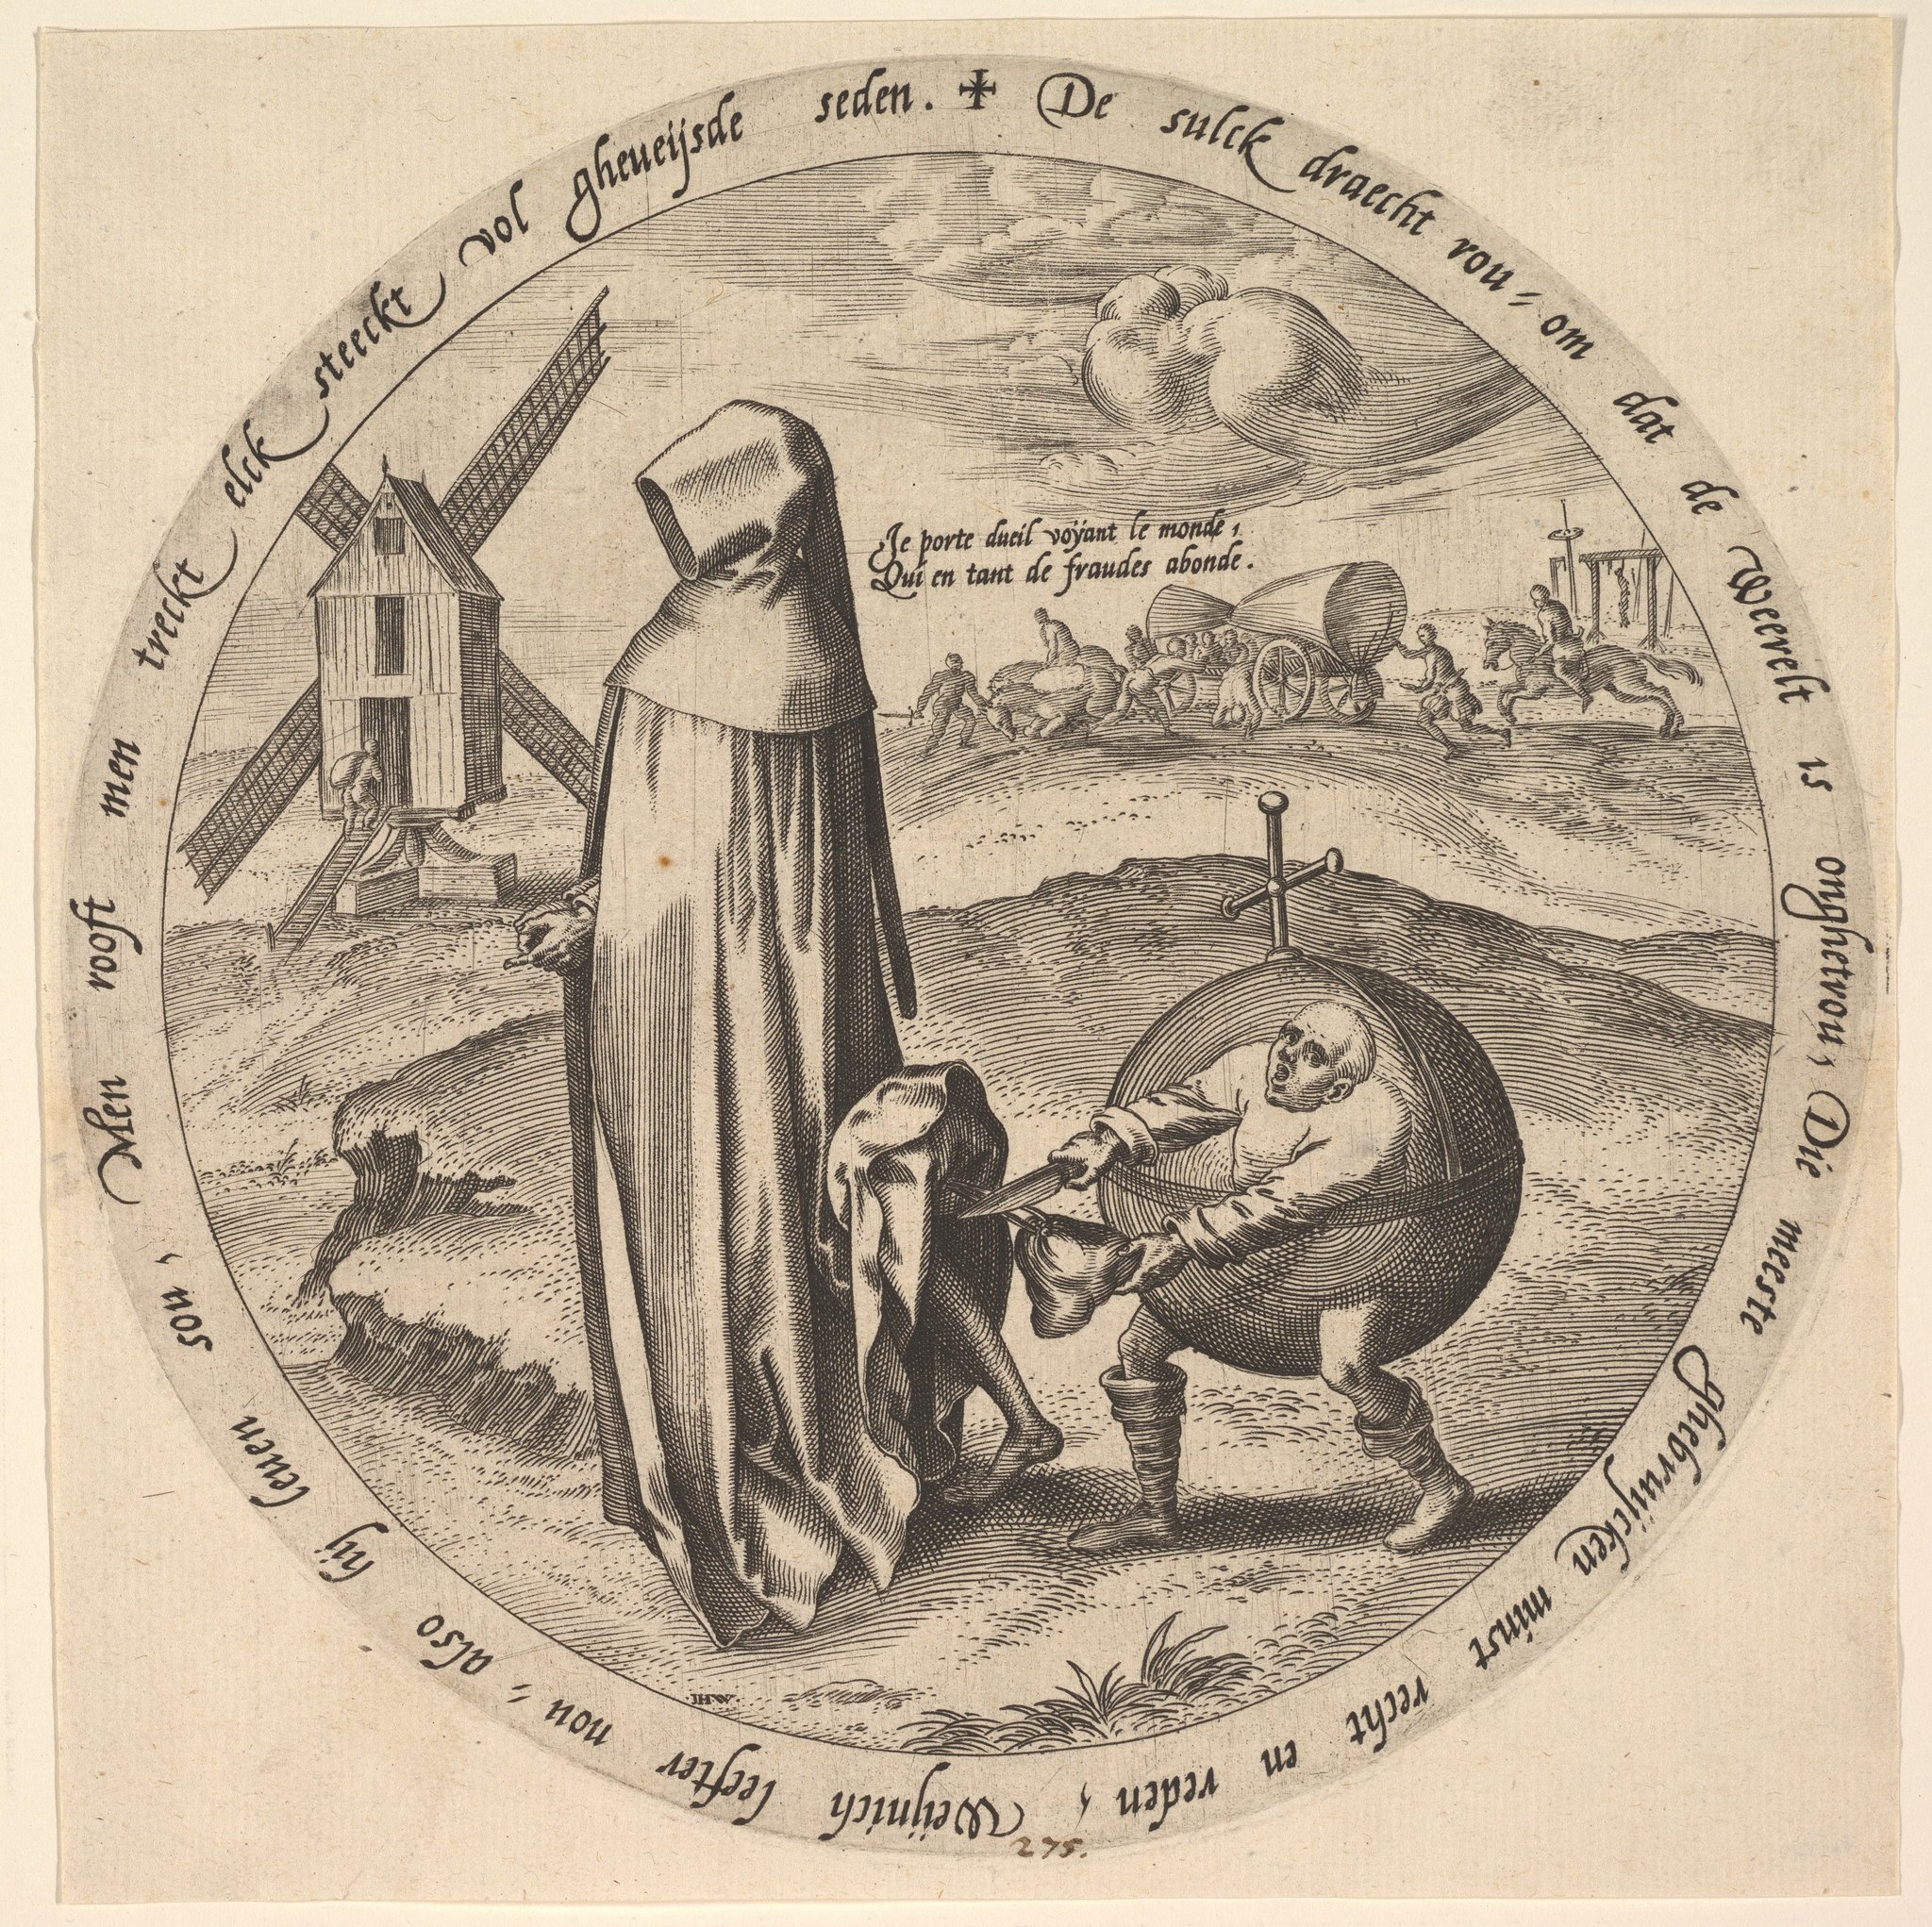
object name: print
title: The Misanthrope Robbed by the World, from Twelve Flemish Proverbs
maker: pieter bruegel the elder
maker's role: artist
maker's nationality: netherlandish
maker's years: 1525-1569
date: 1568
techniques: engraving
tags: windmills,men,horses,carriages